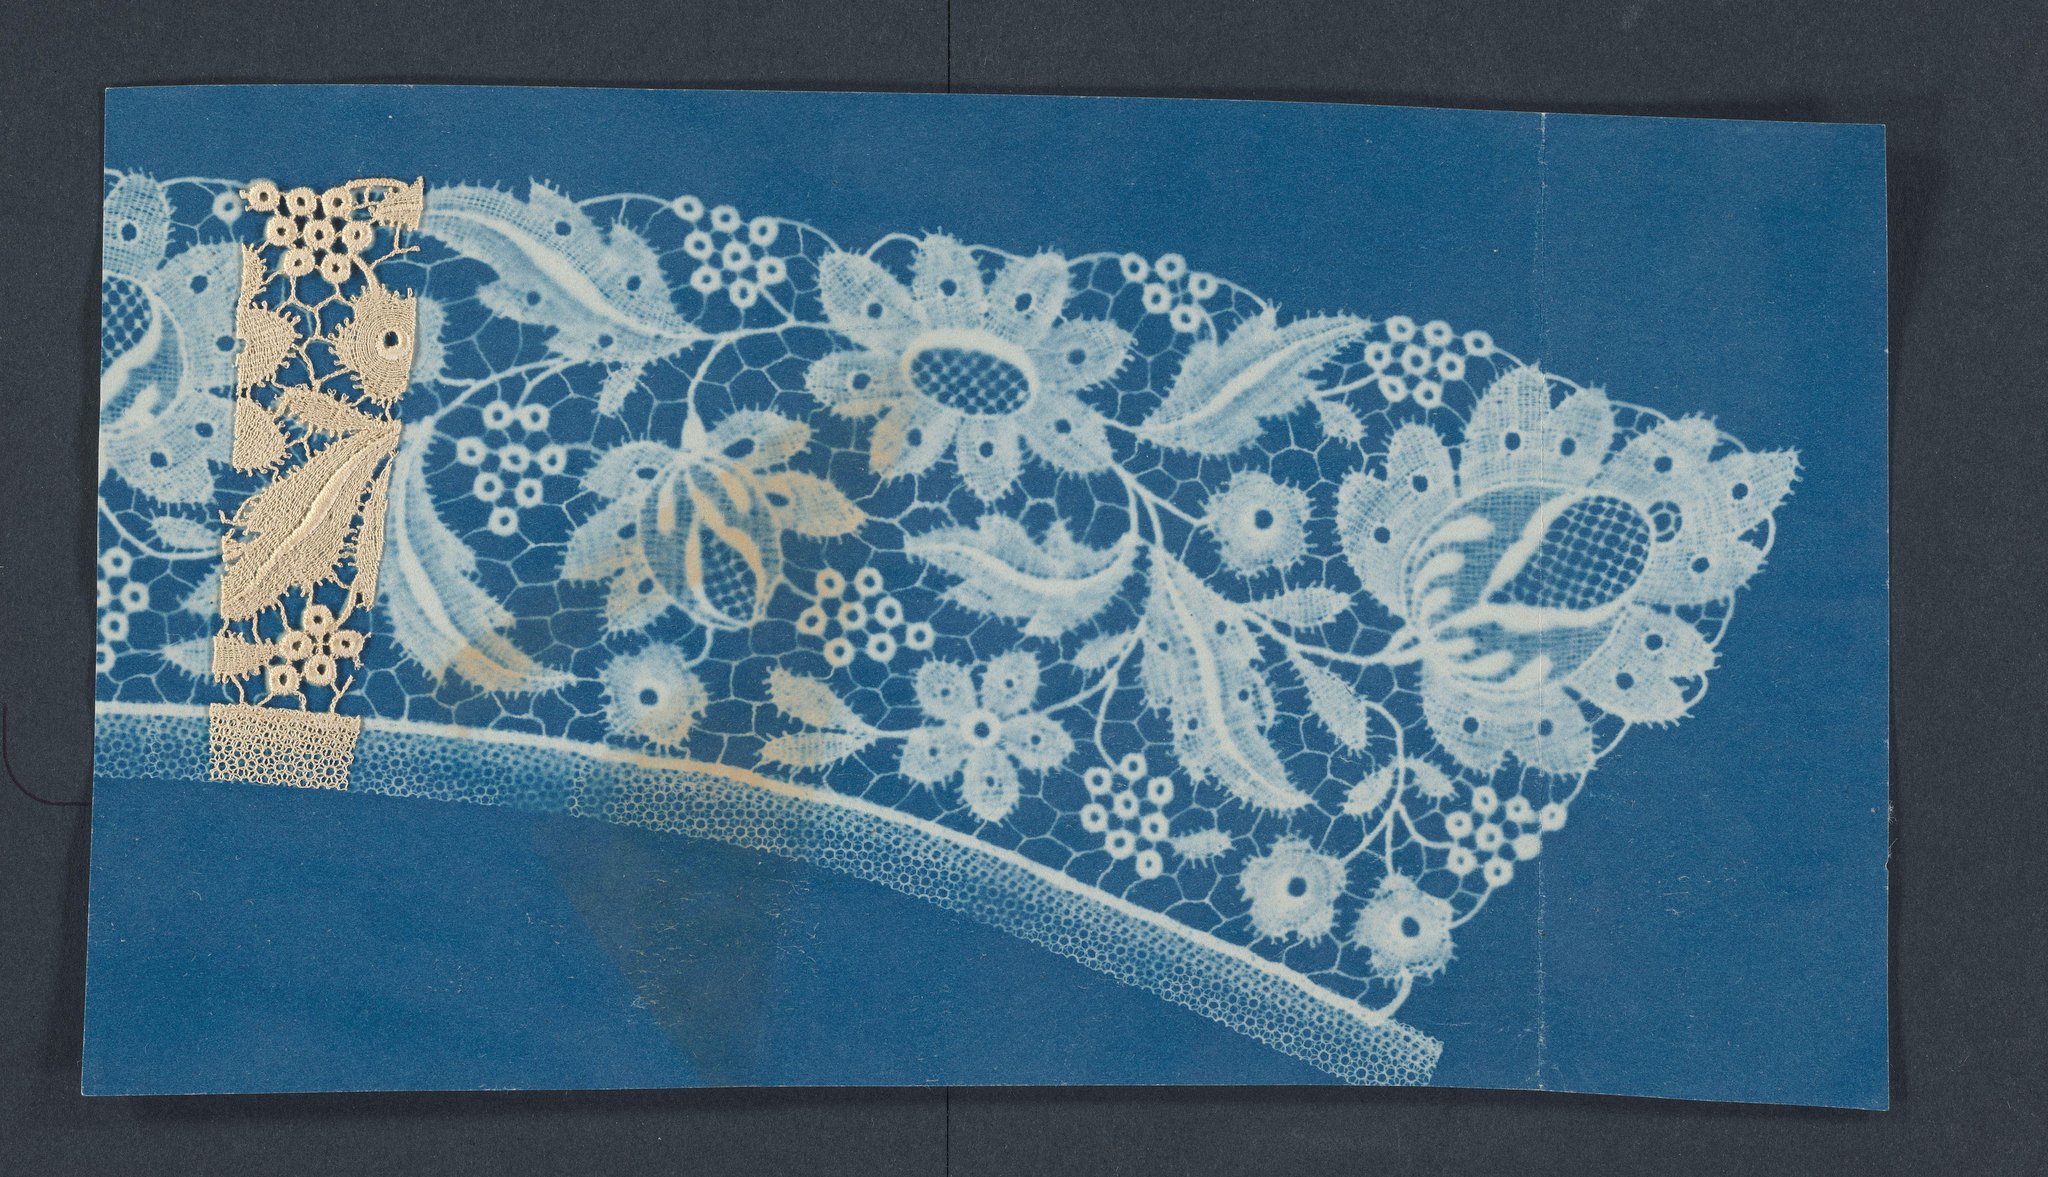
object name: photogram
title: Kant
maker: Anonymous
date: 1900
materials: paper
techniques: cyanotype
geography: france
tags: lace